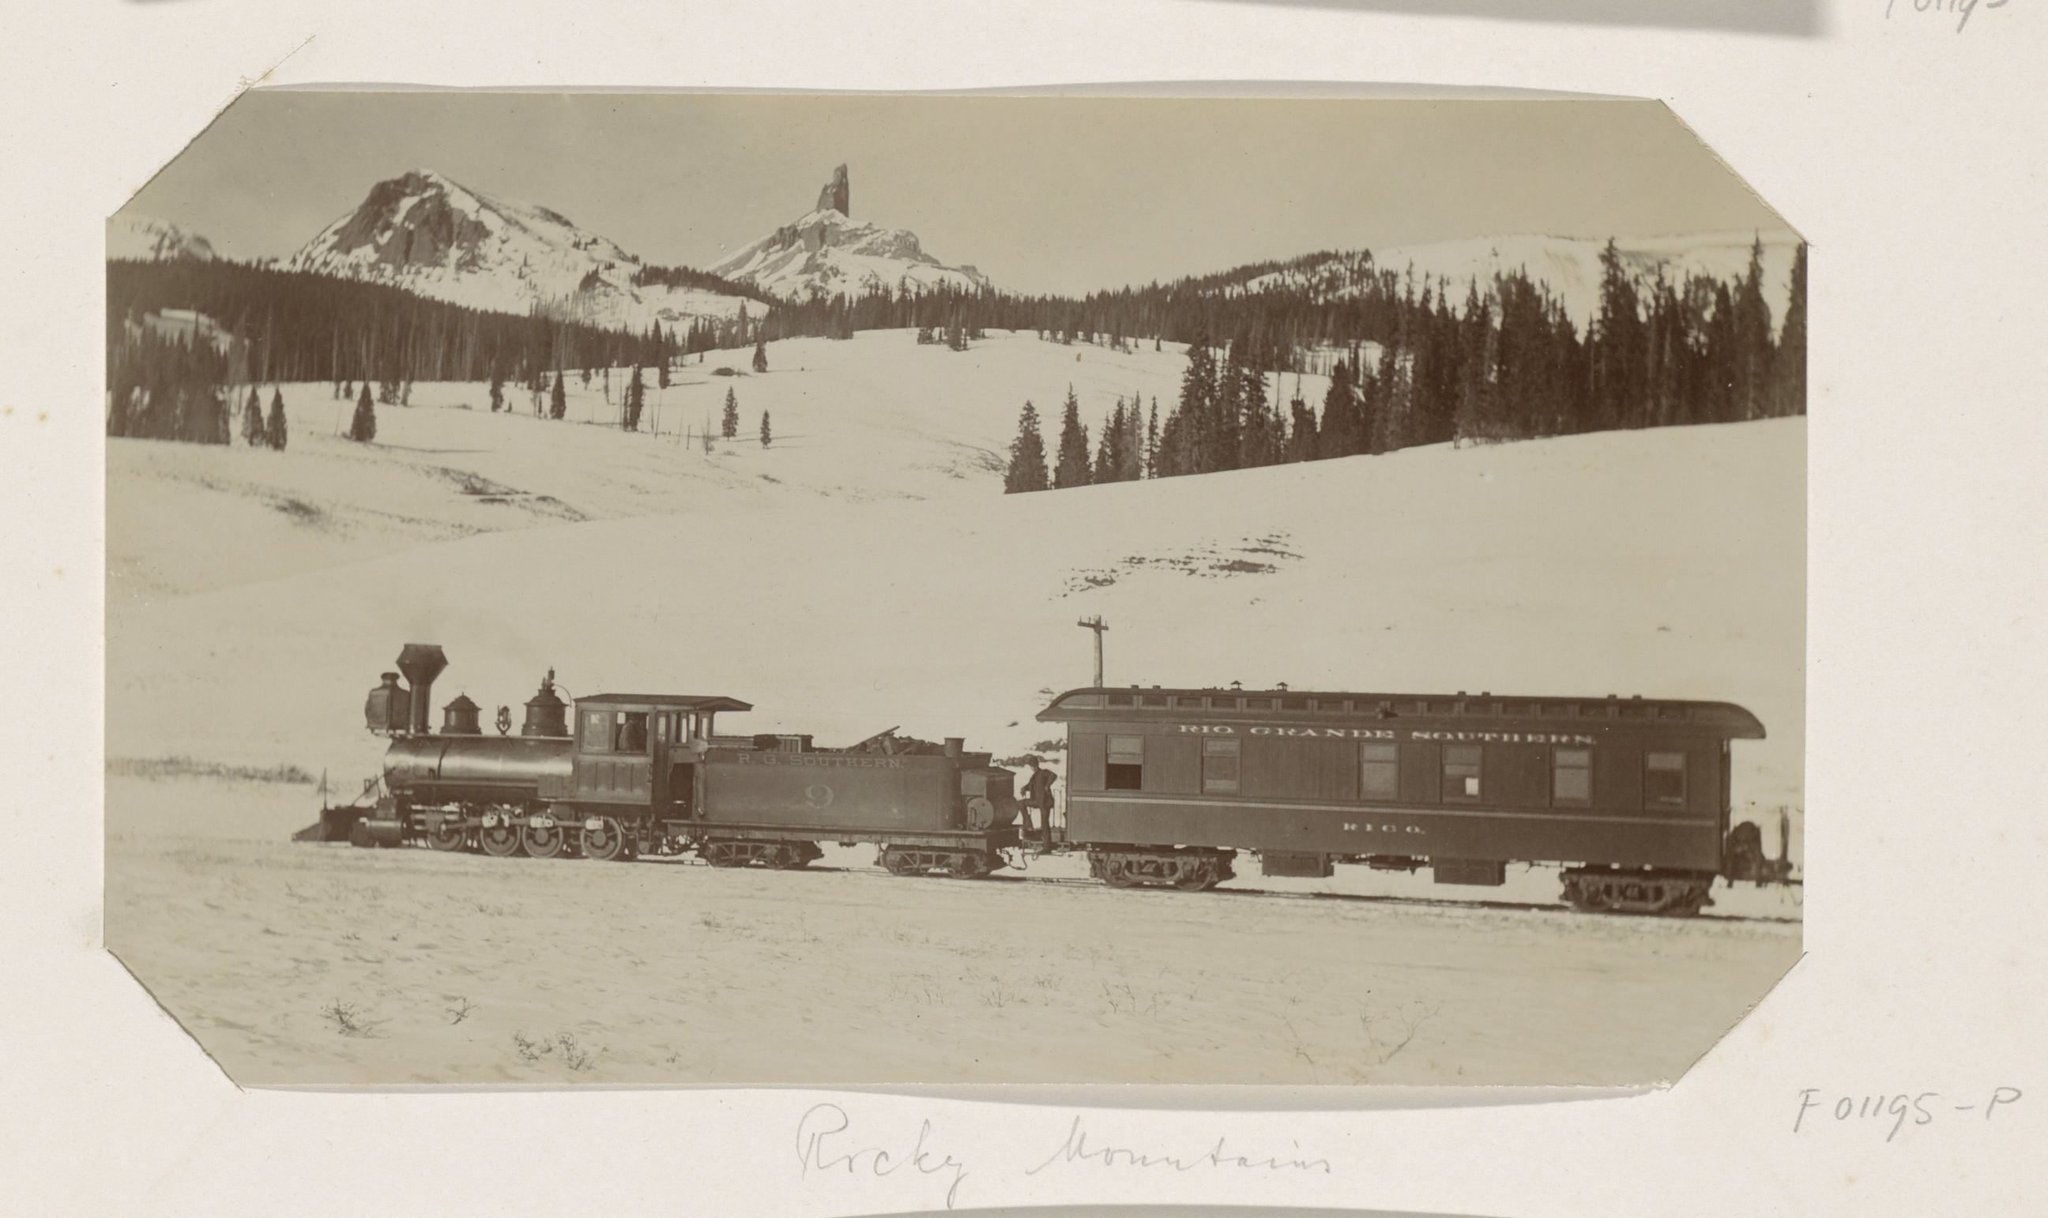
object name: photograph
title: Trein van Rio Grande Southern in besneeuwd landschap in de Rocky Mountains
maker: william henry jackson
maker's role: fotograaf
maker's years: 1843-1942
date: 1860-1900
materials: cardboard, paper, photographic support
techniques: gelatin silver print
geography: rocky mountains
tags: mountain-range, snow peaks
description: Onderdeel van Fotoalbum van een reis door de Verenigde Staten, Honolulu, Nederlands-Indië, Aden, Zanzibar en Zuidelijk Afrika.